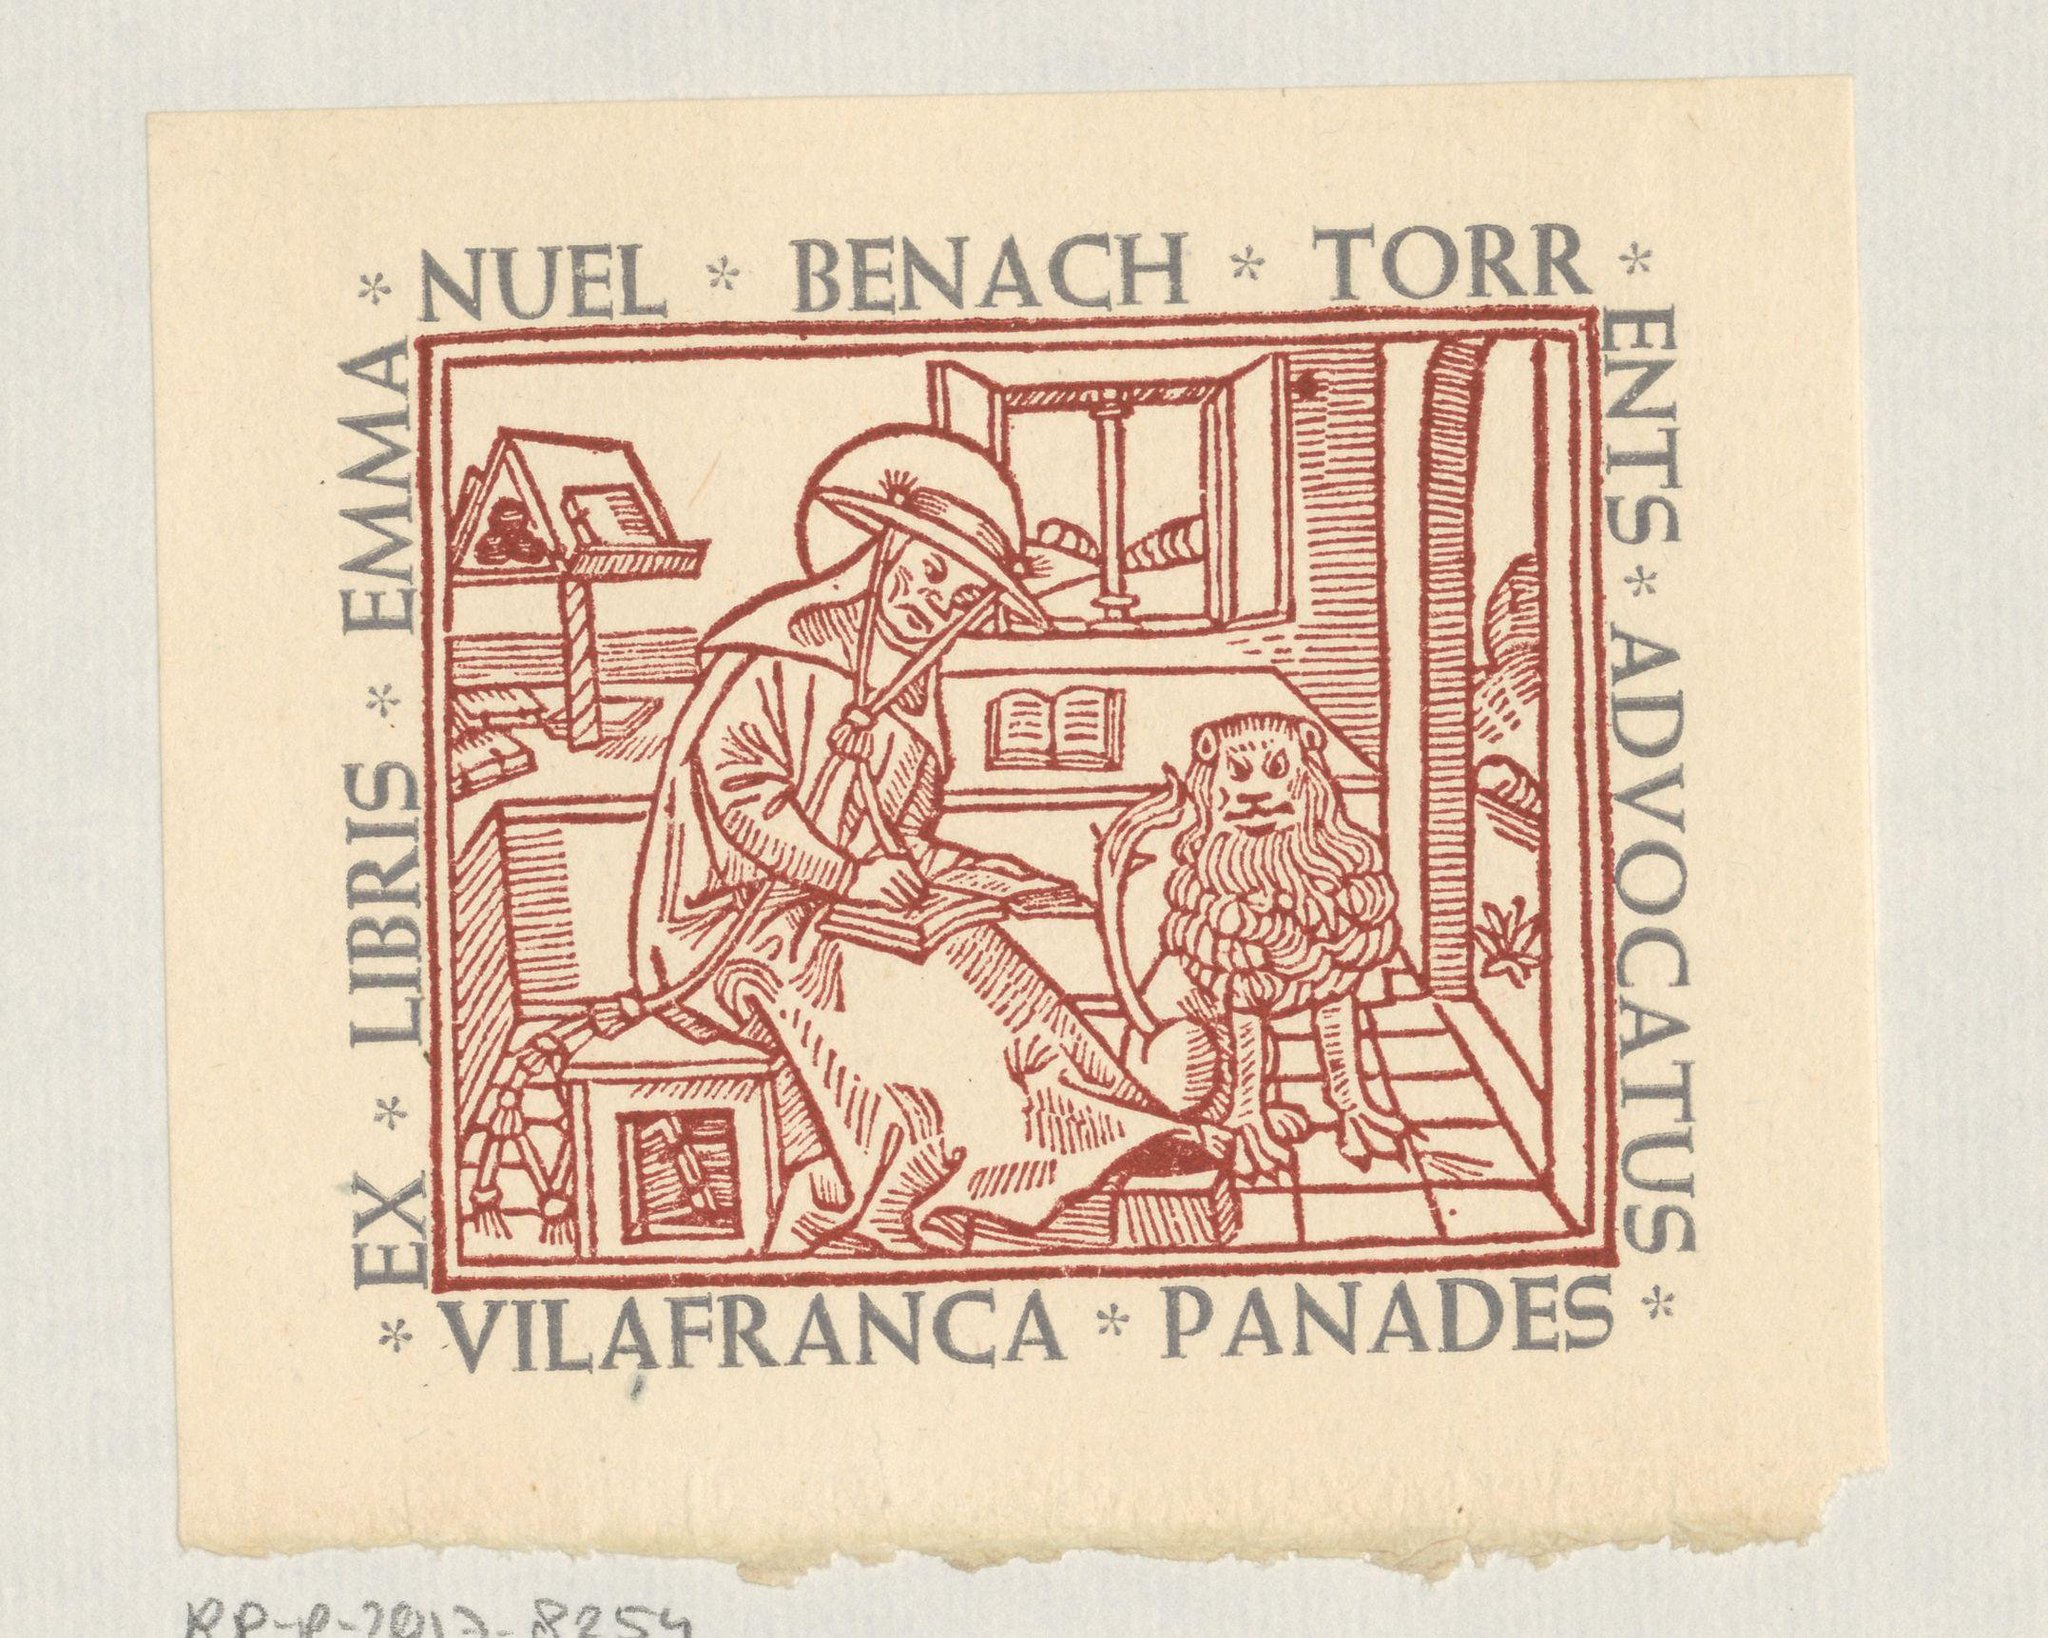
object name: bookplate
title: Ex libris Emmanuel Benach Torrents advocatus vilafranca panades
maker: Anonymous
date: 1900-1949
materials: paper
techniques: printing block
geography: spain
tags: the monk and hermit jerome (hieronymus); possible attributes: book, cardinal's hat, crucifix, hour-glass, lion, skull, stone, beasts of prey, predatory animals: lion